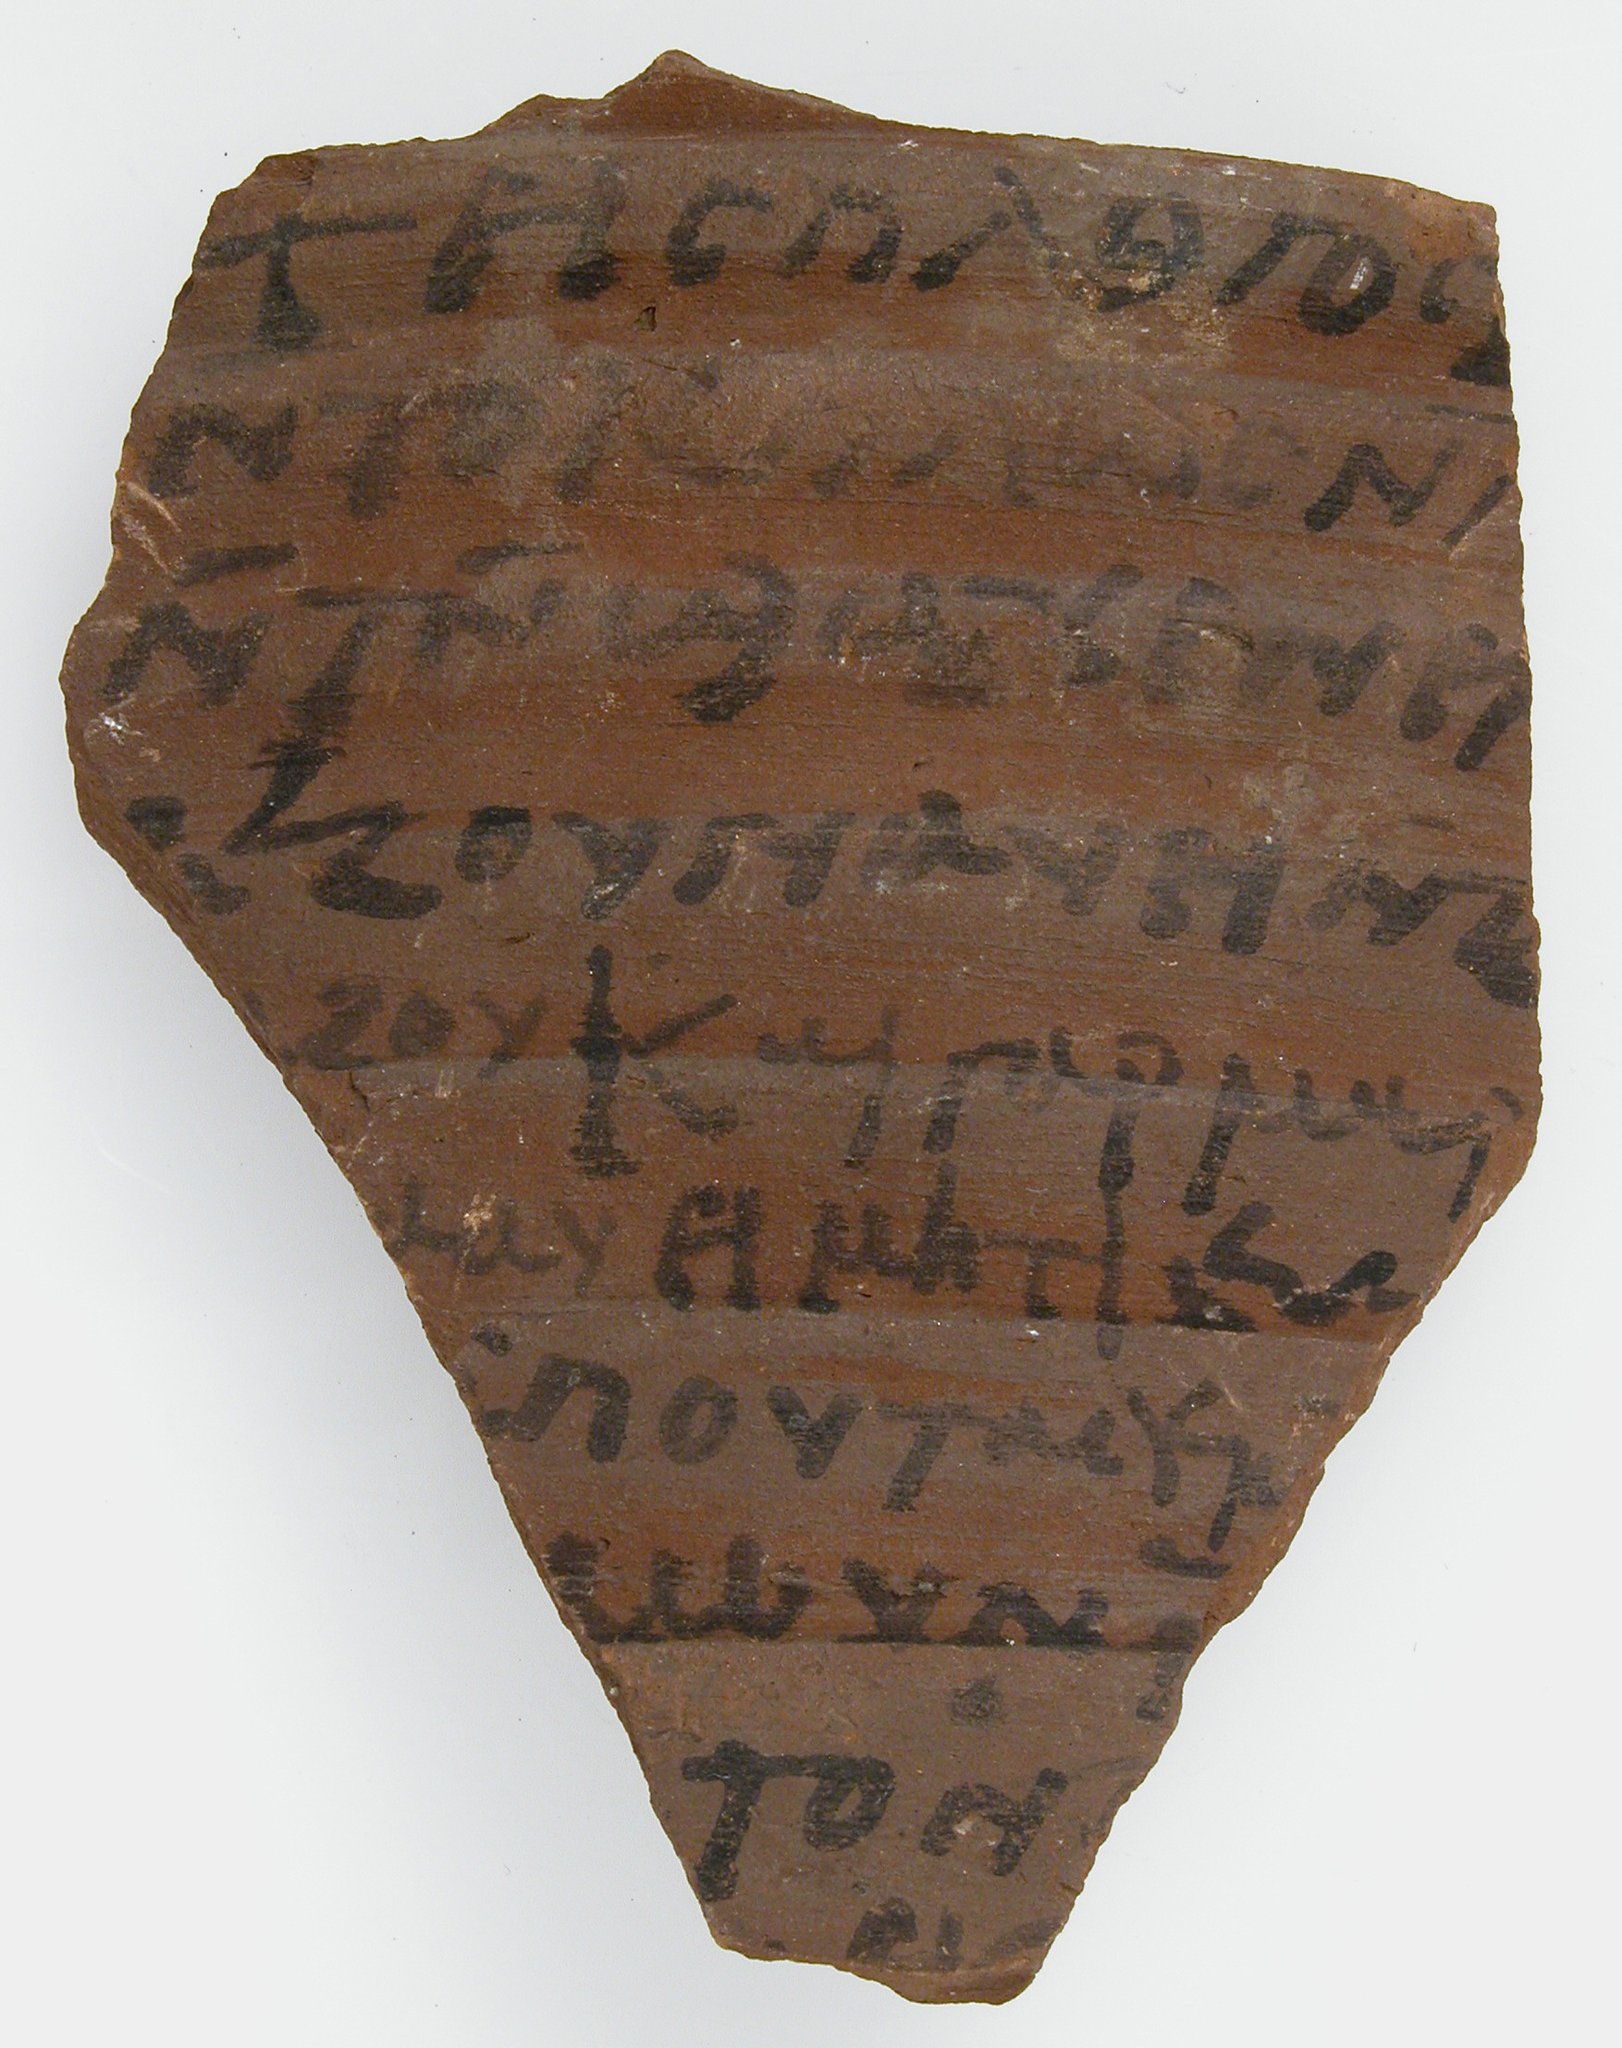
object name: ostrakon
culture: coptic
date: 600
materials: ink, pottery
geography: egypt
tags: coptic,documents